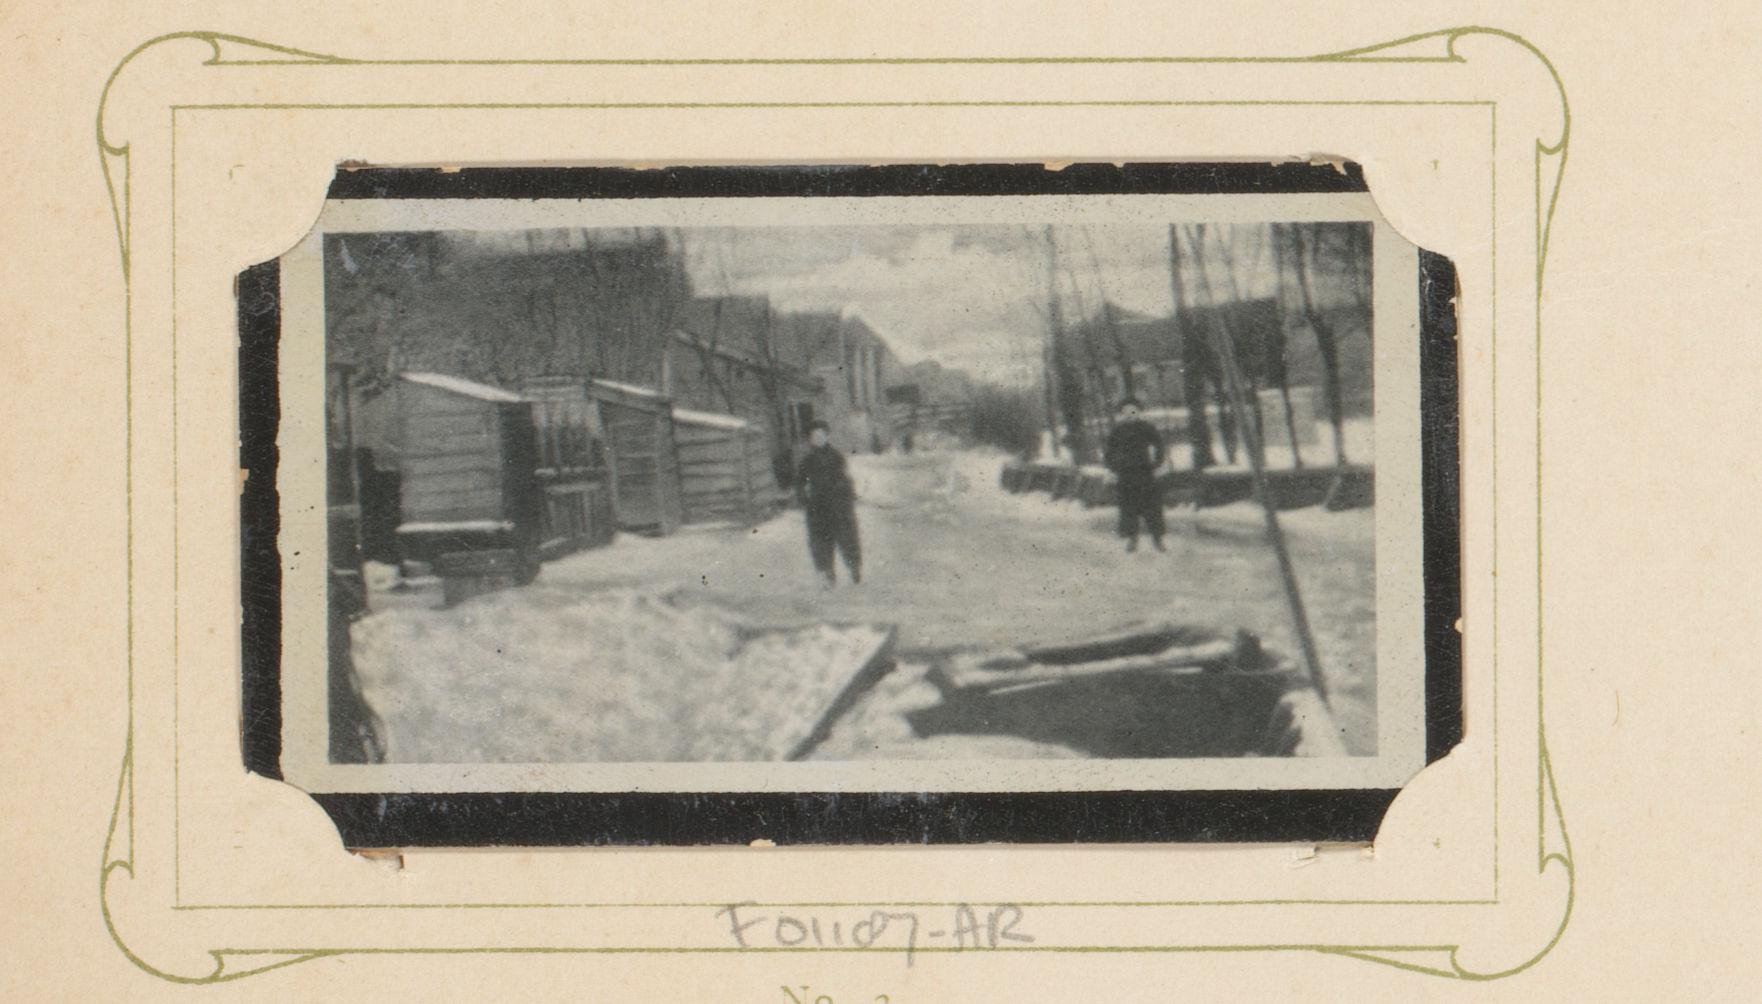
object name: album leaf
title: Dorpsgezicht met sneeuw en ijs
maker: Anonymous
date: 1905-1906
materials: paper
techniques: photograph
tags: winter landscape; landscape symbolizing winter (the four seasons of the year), prospect of village, silhouette of village (+ city(-scape) with figures, staffage)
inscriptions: inscription: ‘No. 3./ Het had hard gevroren.’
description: Deze prent maakt deel uit van een album.